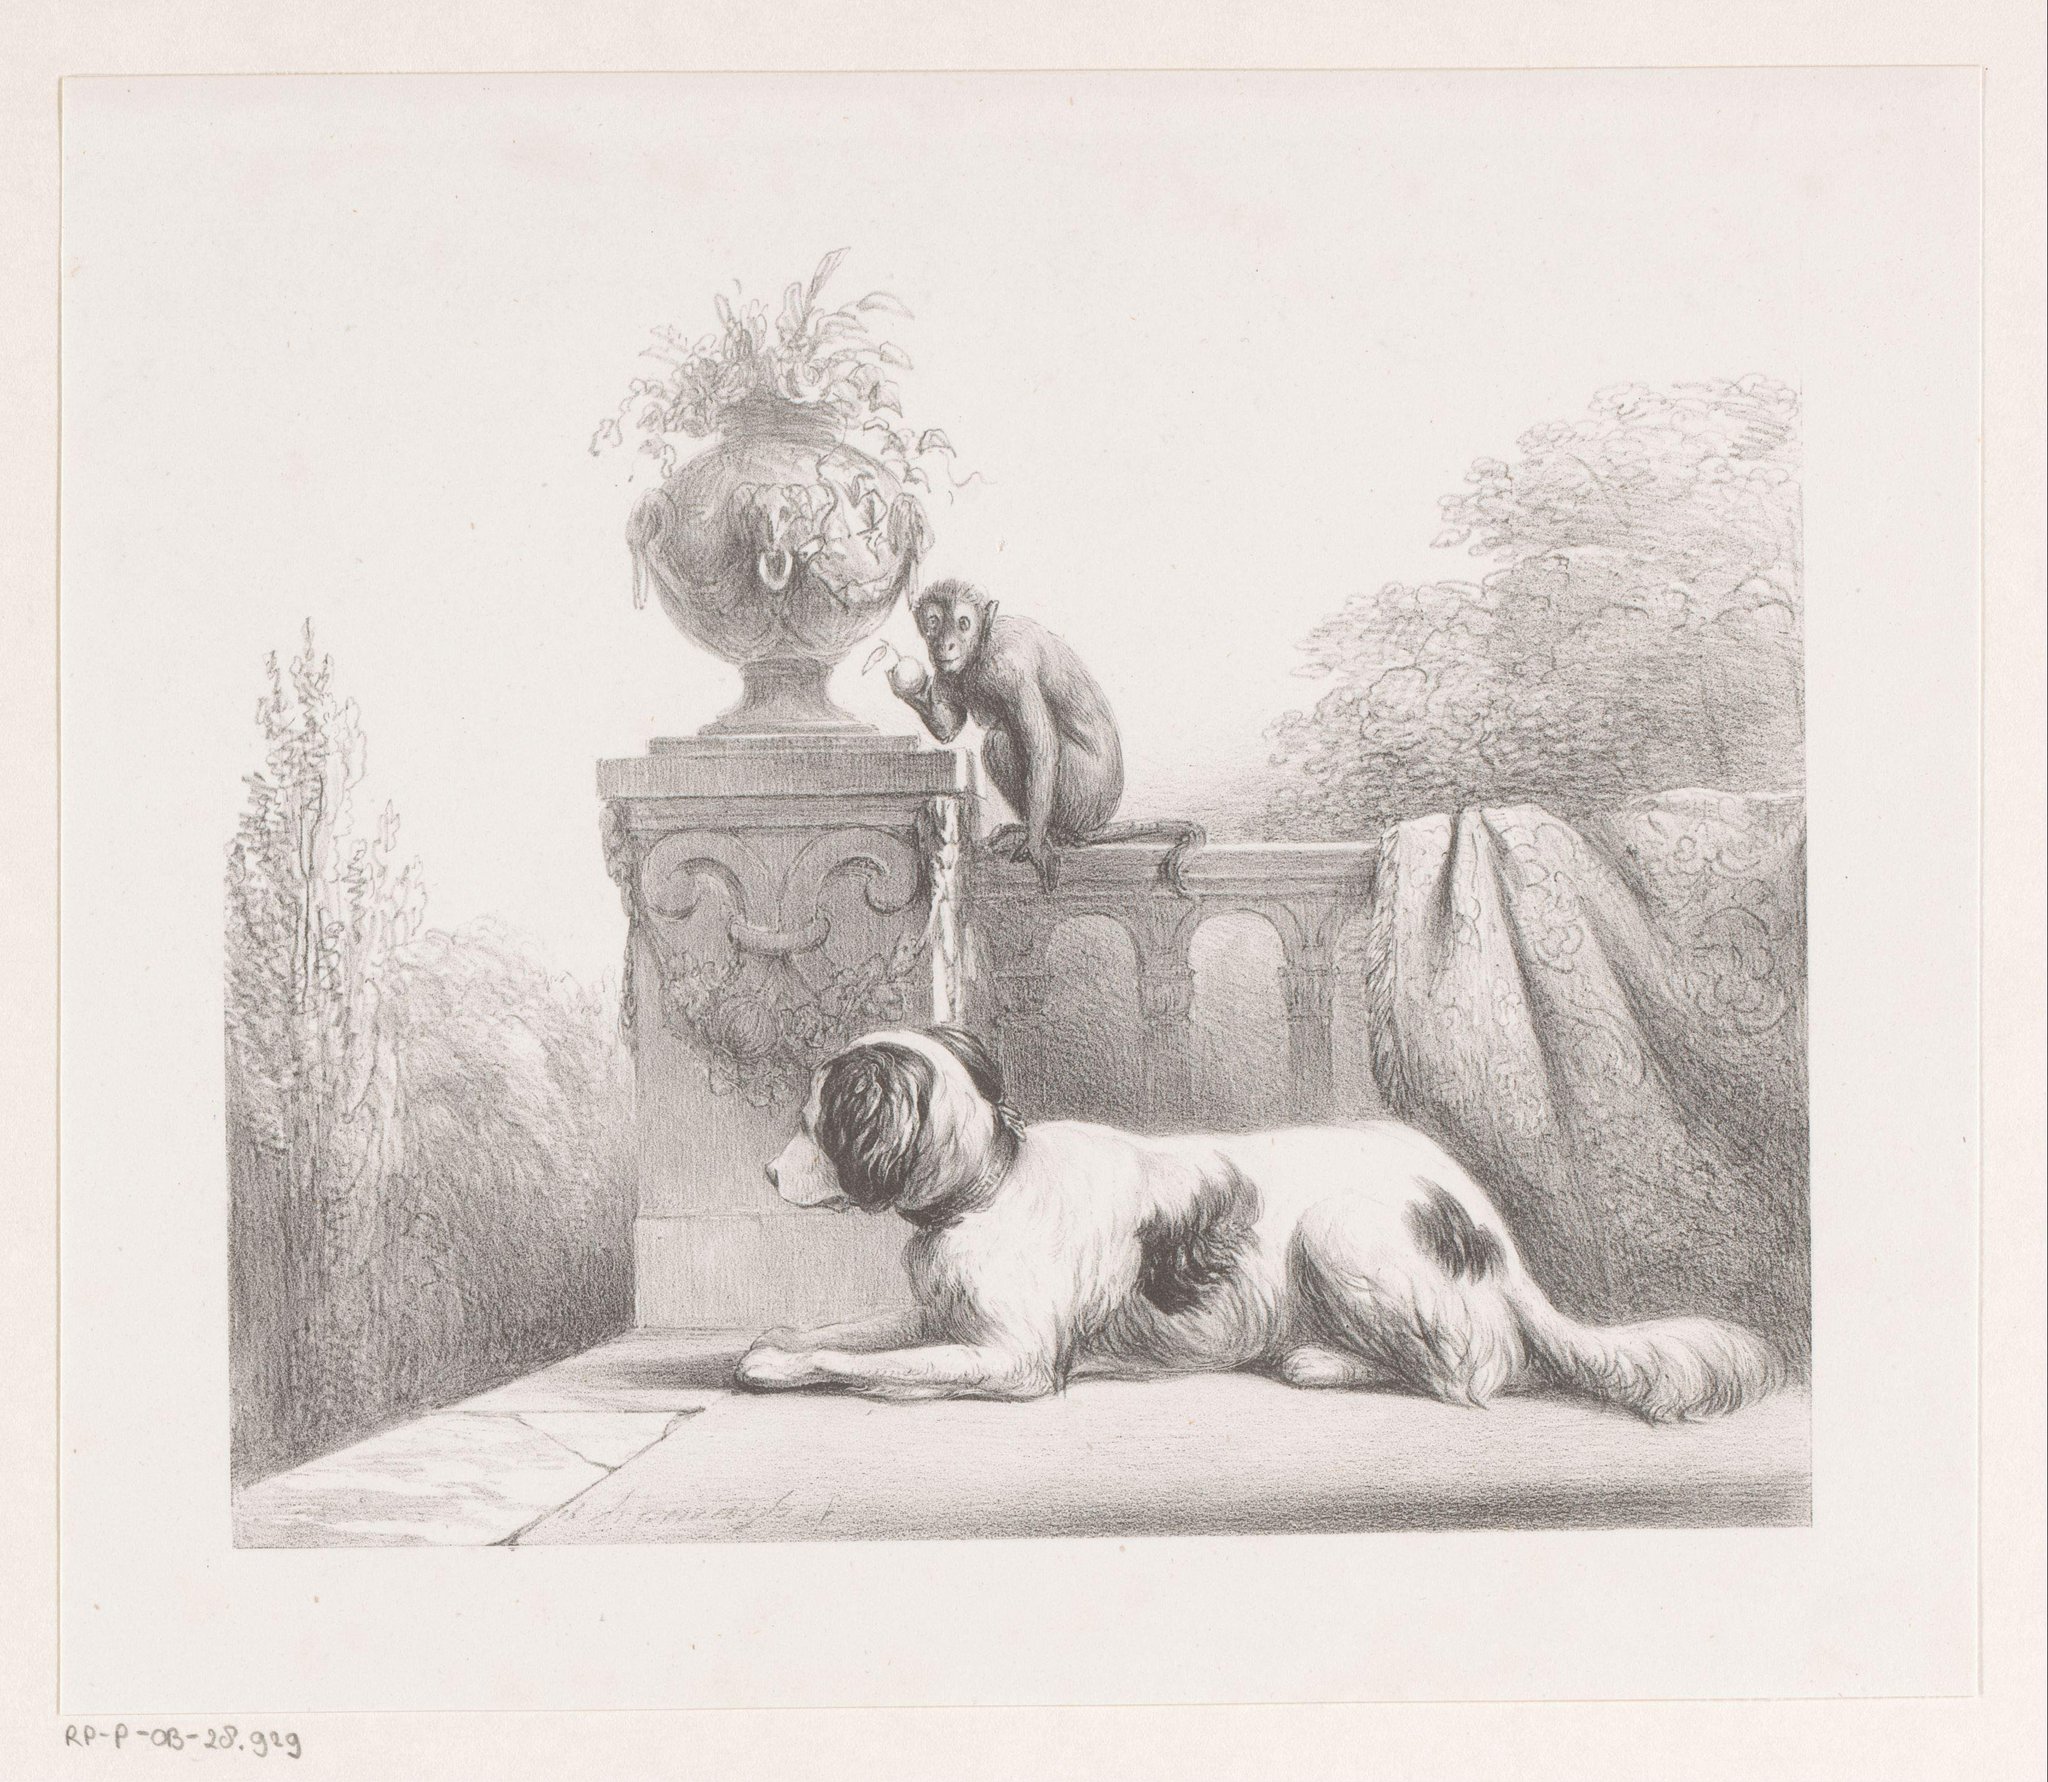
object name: print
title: Hond en aap op terras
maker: arie ketting de koningh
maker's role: print maker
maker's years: 1815-1867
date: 1849-1859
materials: paper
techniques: lithograph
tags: monkeys, apes, terrace, dog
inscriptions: collector's mark: Lugt 2228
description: De aap zit naast een tuinvaas en heeft een appel in zijn poot. Rechts ligt een kleed over de balustrade.